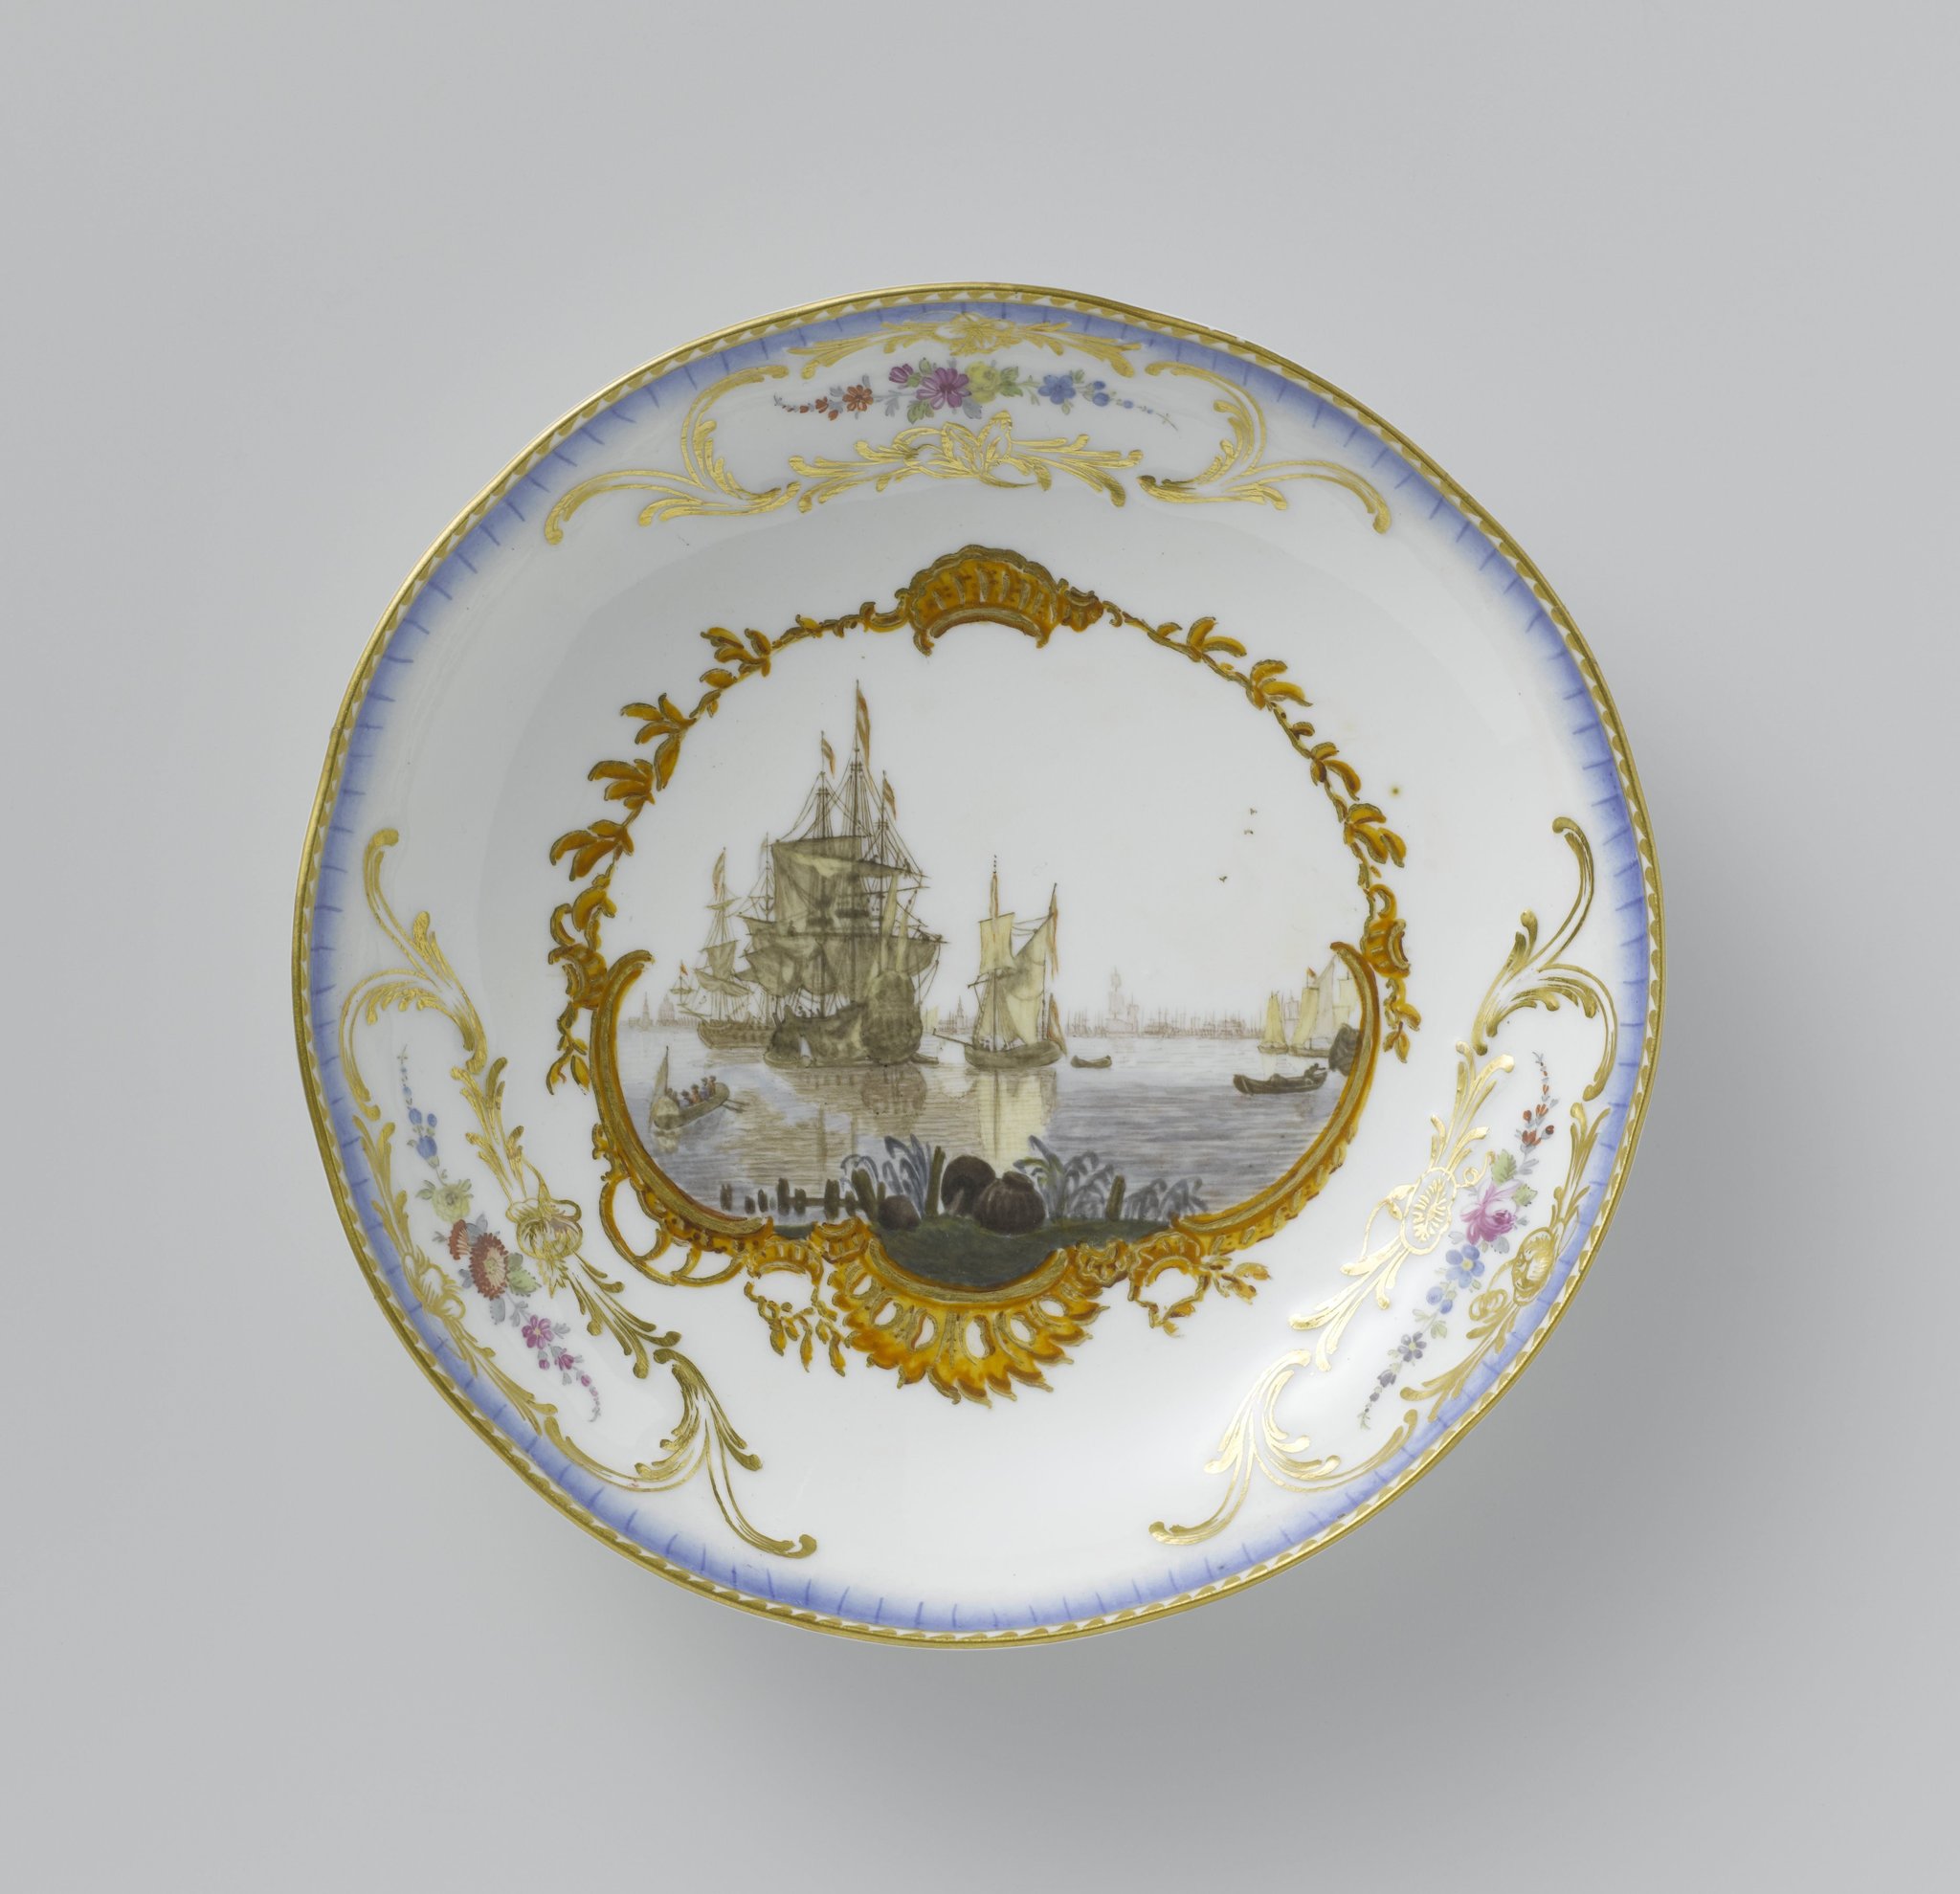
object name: eating drinking utensil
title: Seven plates from the service of Stadtholder William v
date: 1772-1774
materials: porcelain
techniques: painted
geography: meissen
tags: the hague, william v (prince of orange)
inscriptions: painter's mark: ‘J’, inscription: ‘Amsterdam’, mold mark: ‘54’, mark, factory mark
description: These seven plates are from a 435-part service owned by Stadtholder William v of Orange. The service was produced in Meissen between 1772 and 1774, possibly on commission for the Dutch East India Company (VOC). The plates bear scenes of various Dutch cities and buildings, as well as views of Java and Ceylon, then important Company territories.